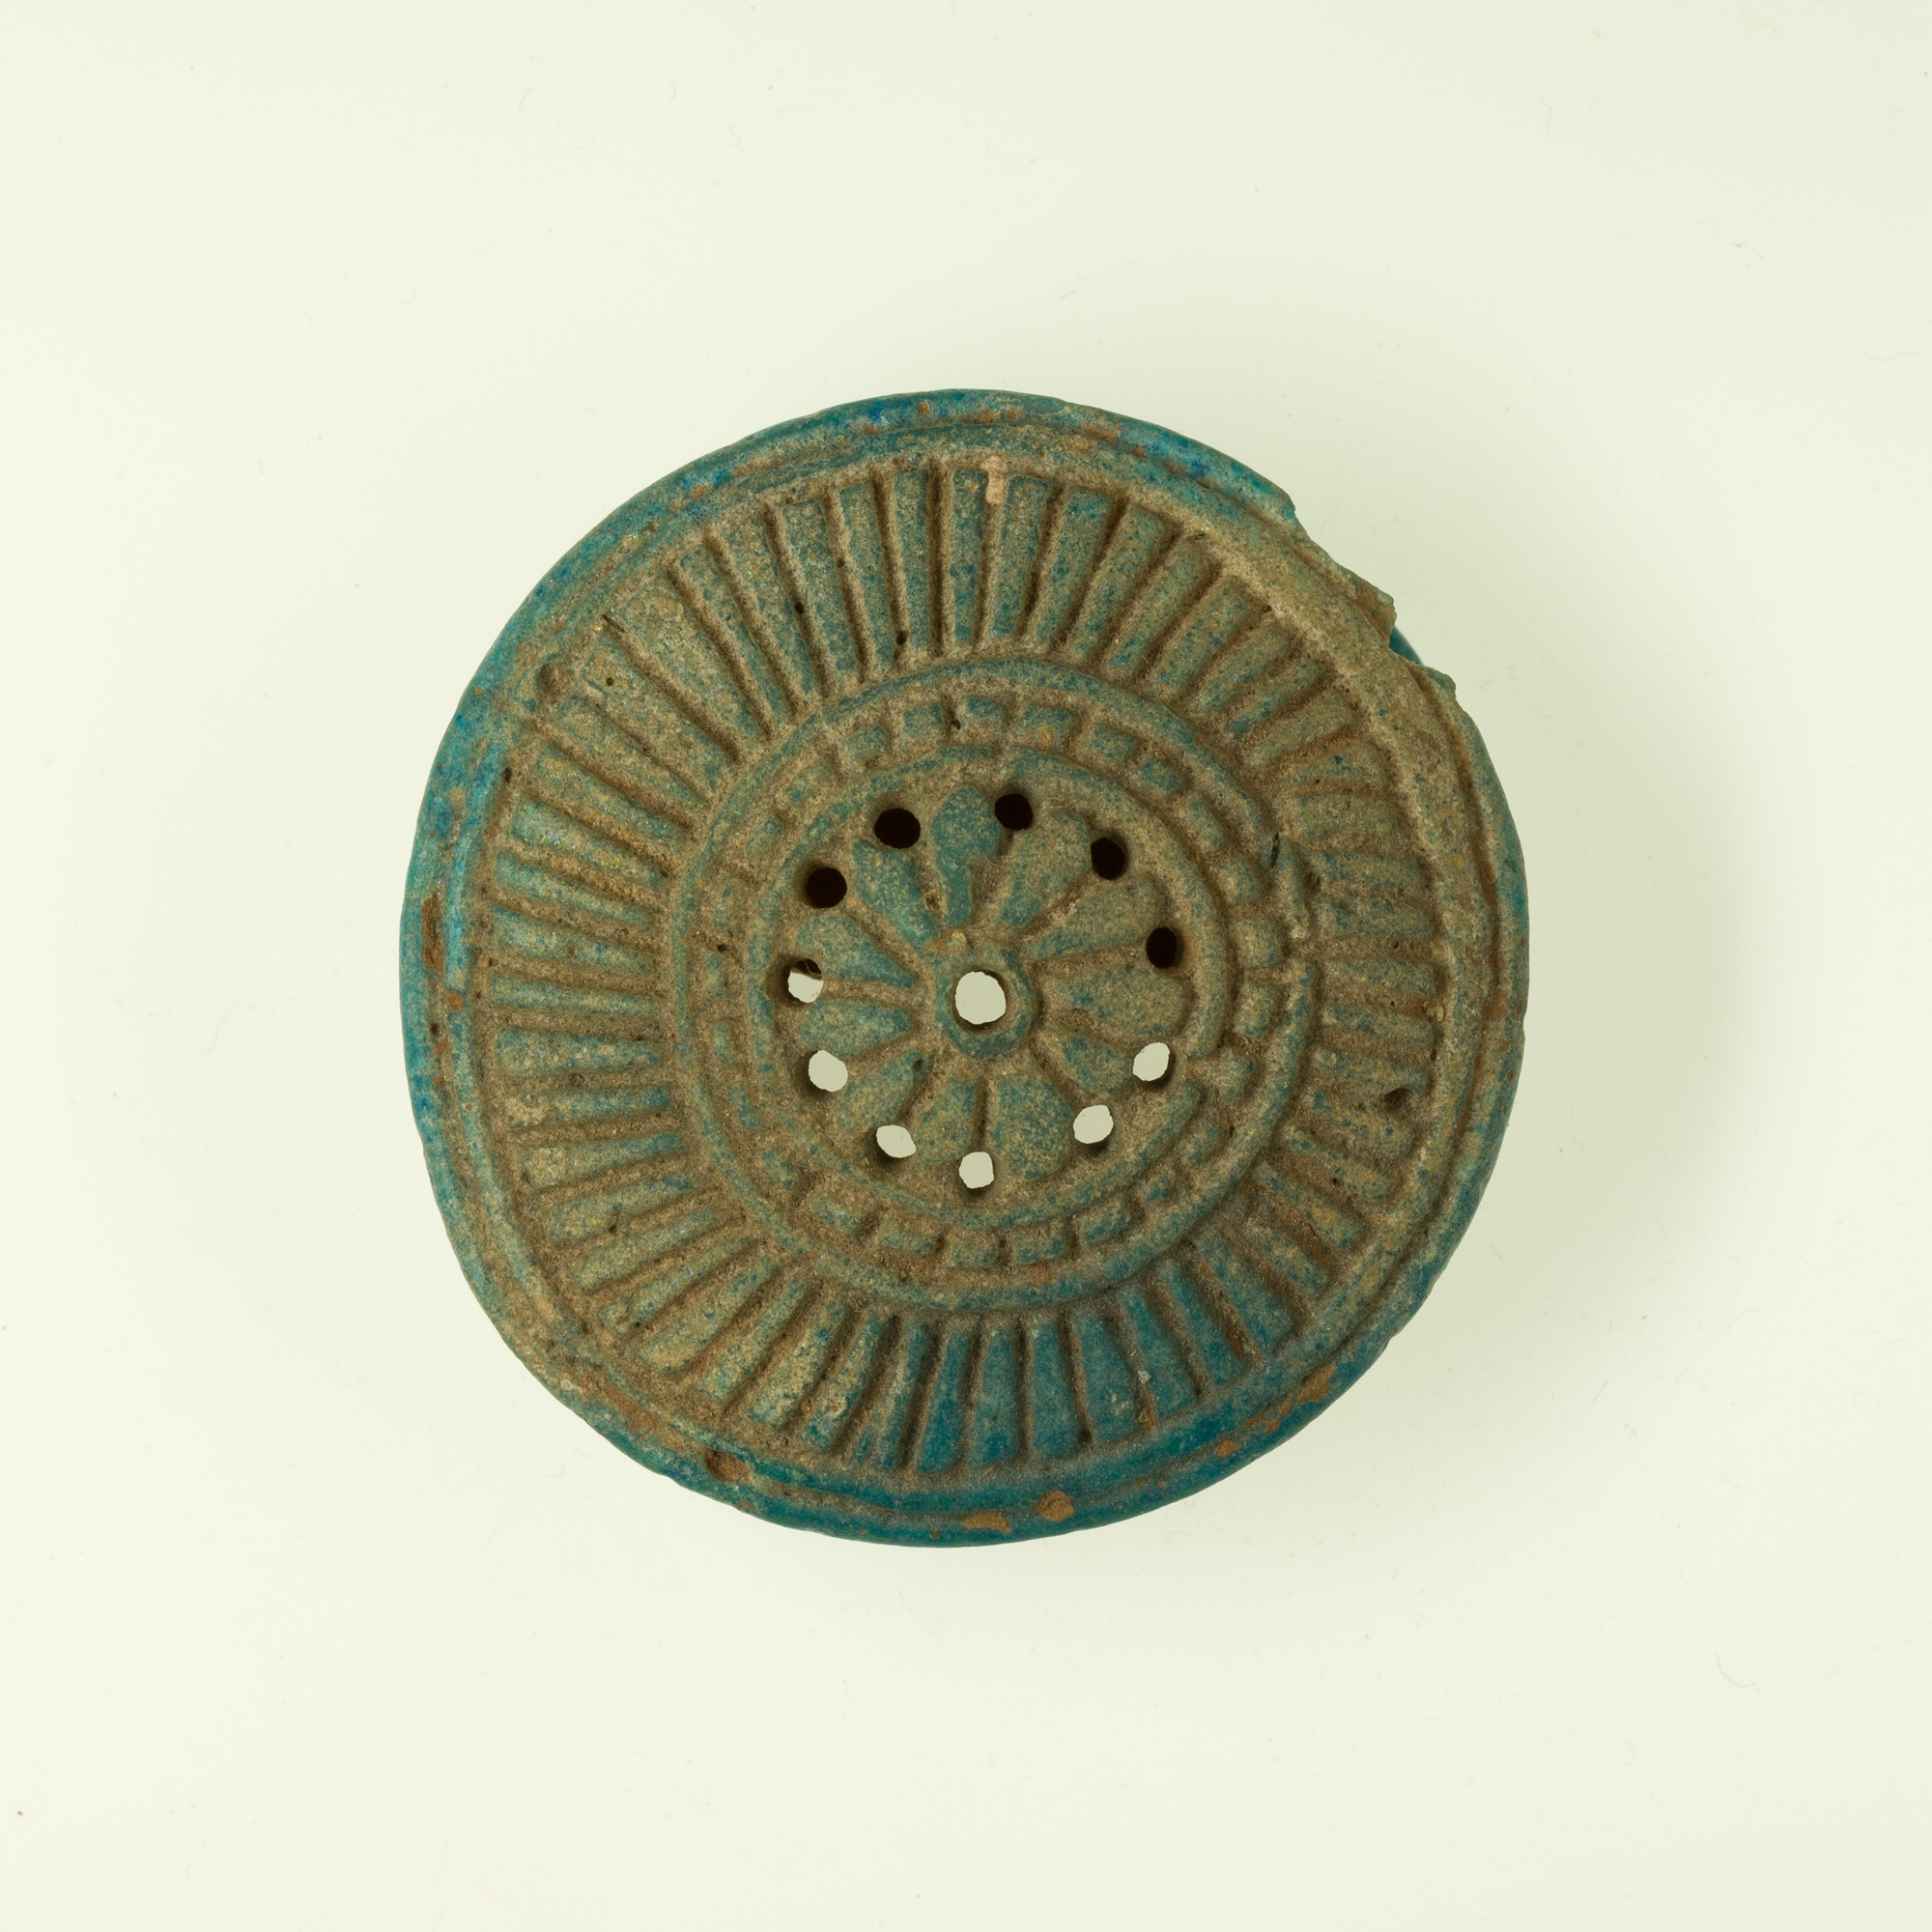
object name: ear plug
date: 1295-1070 BCE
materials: faience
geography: egypt